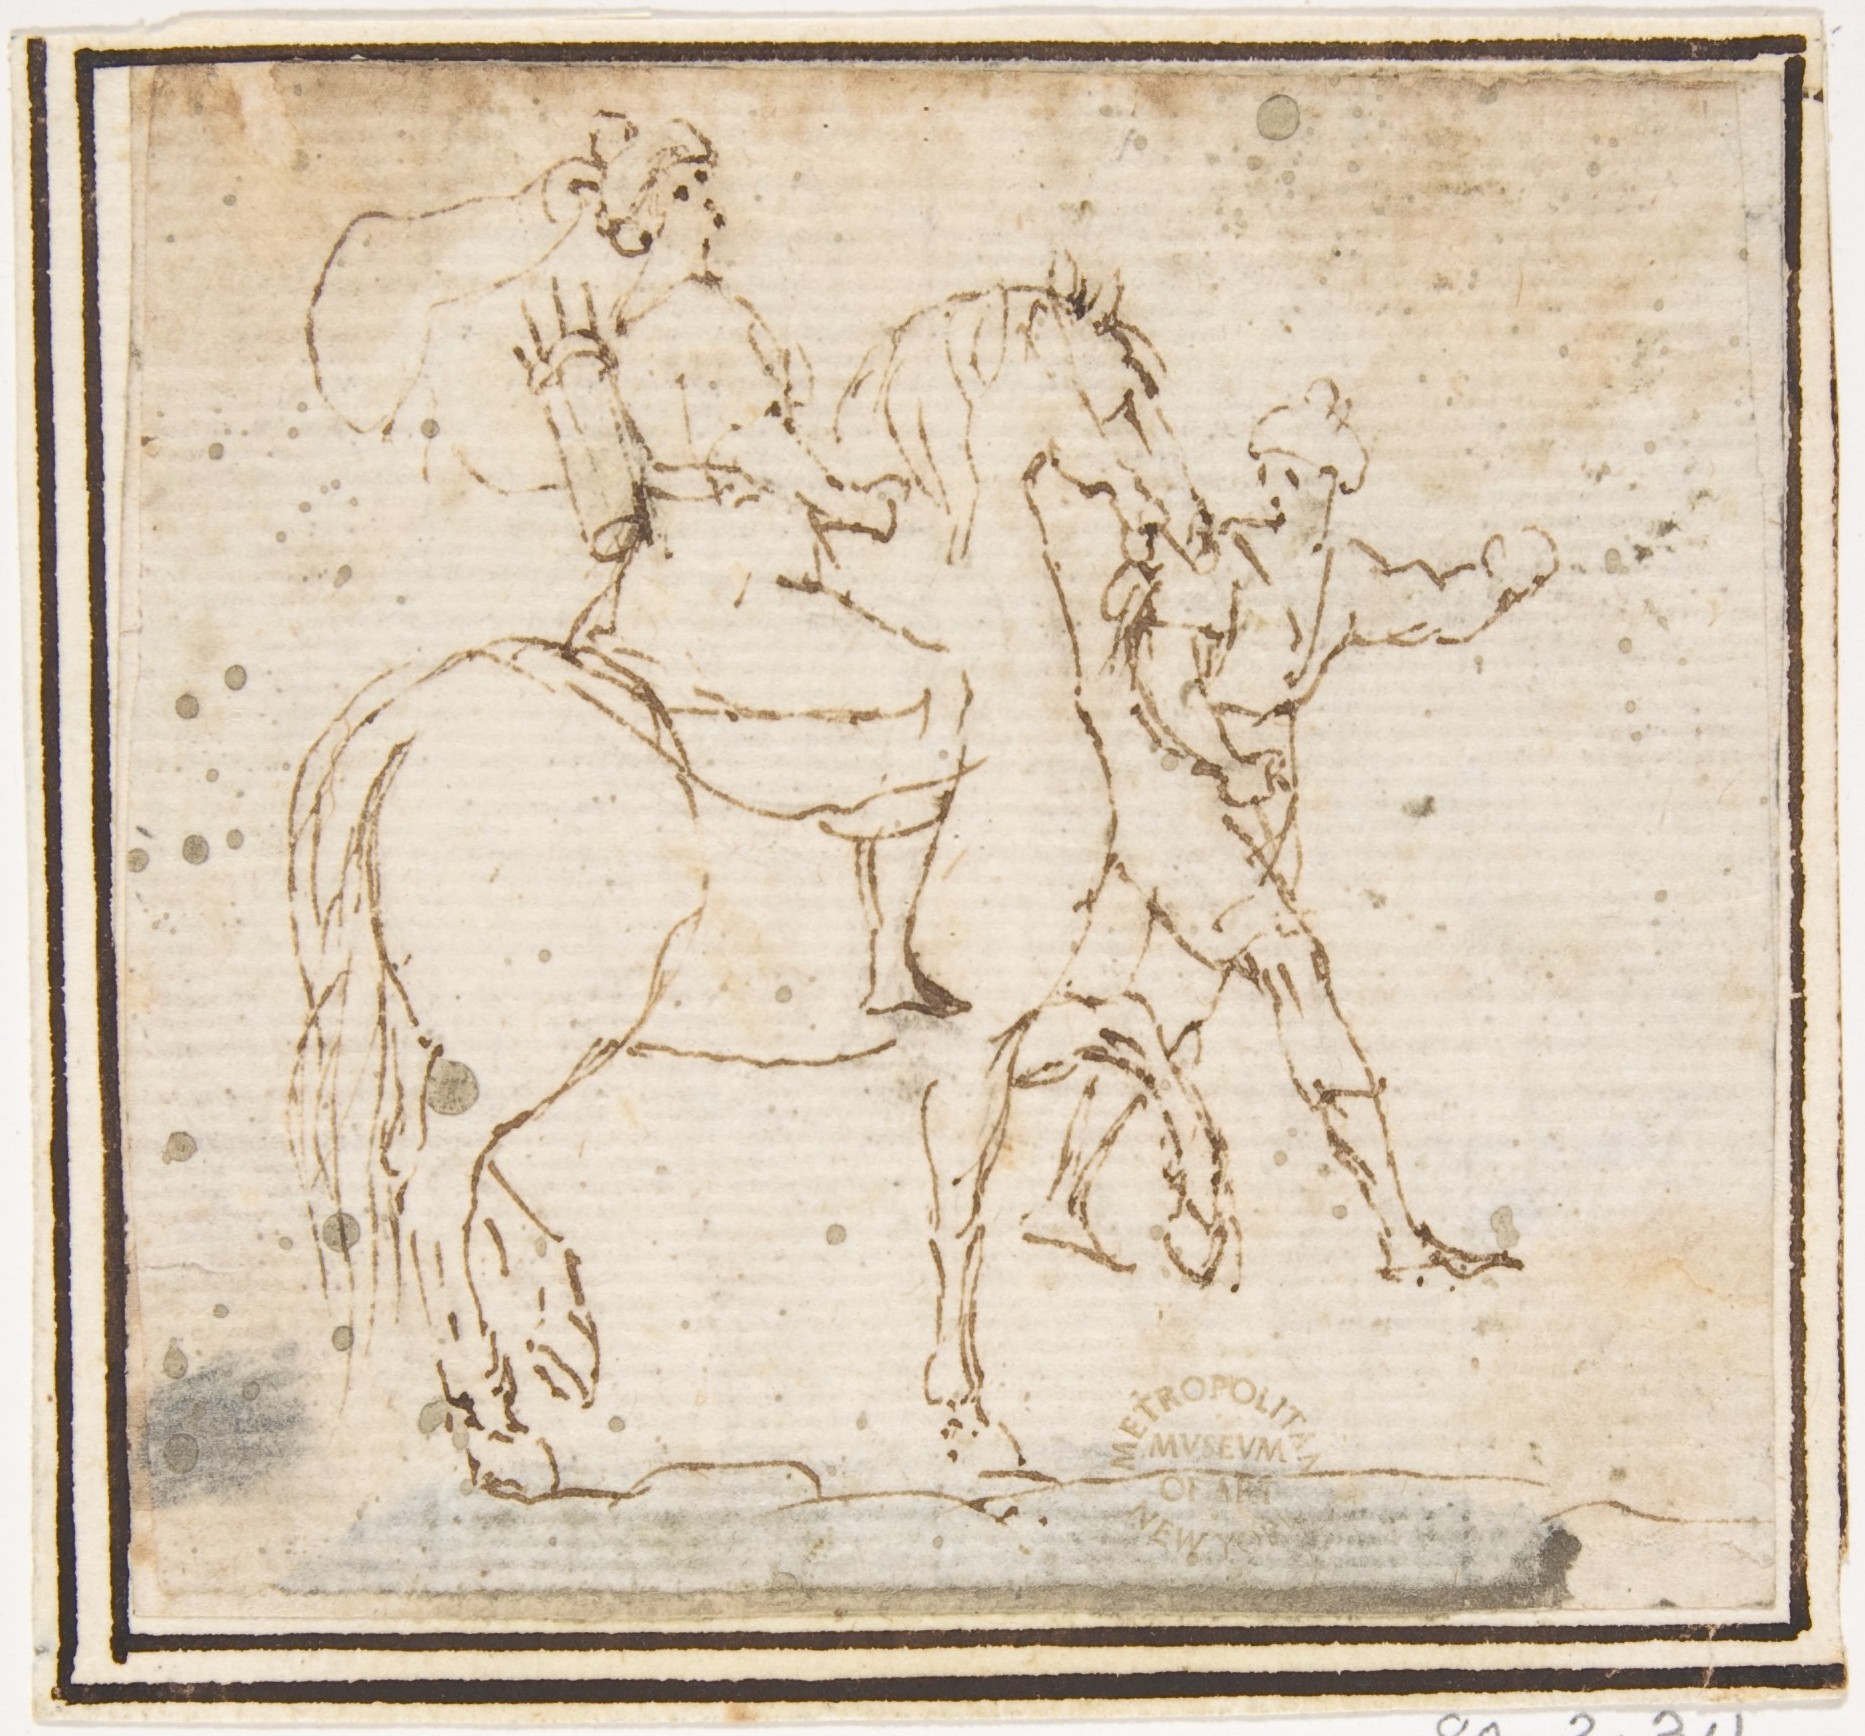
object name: drawing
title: Man on Horseback with Attendant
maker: francesco allegrini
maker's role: artist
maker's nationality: italian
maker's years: 1615-1679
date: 1624-1663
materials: ink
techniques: pen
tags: men,horses